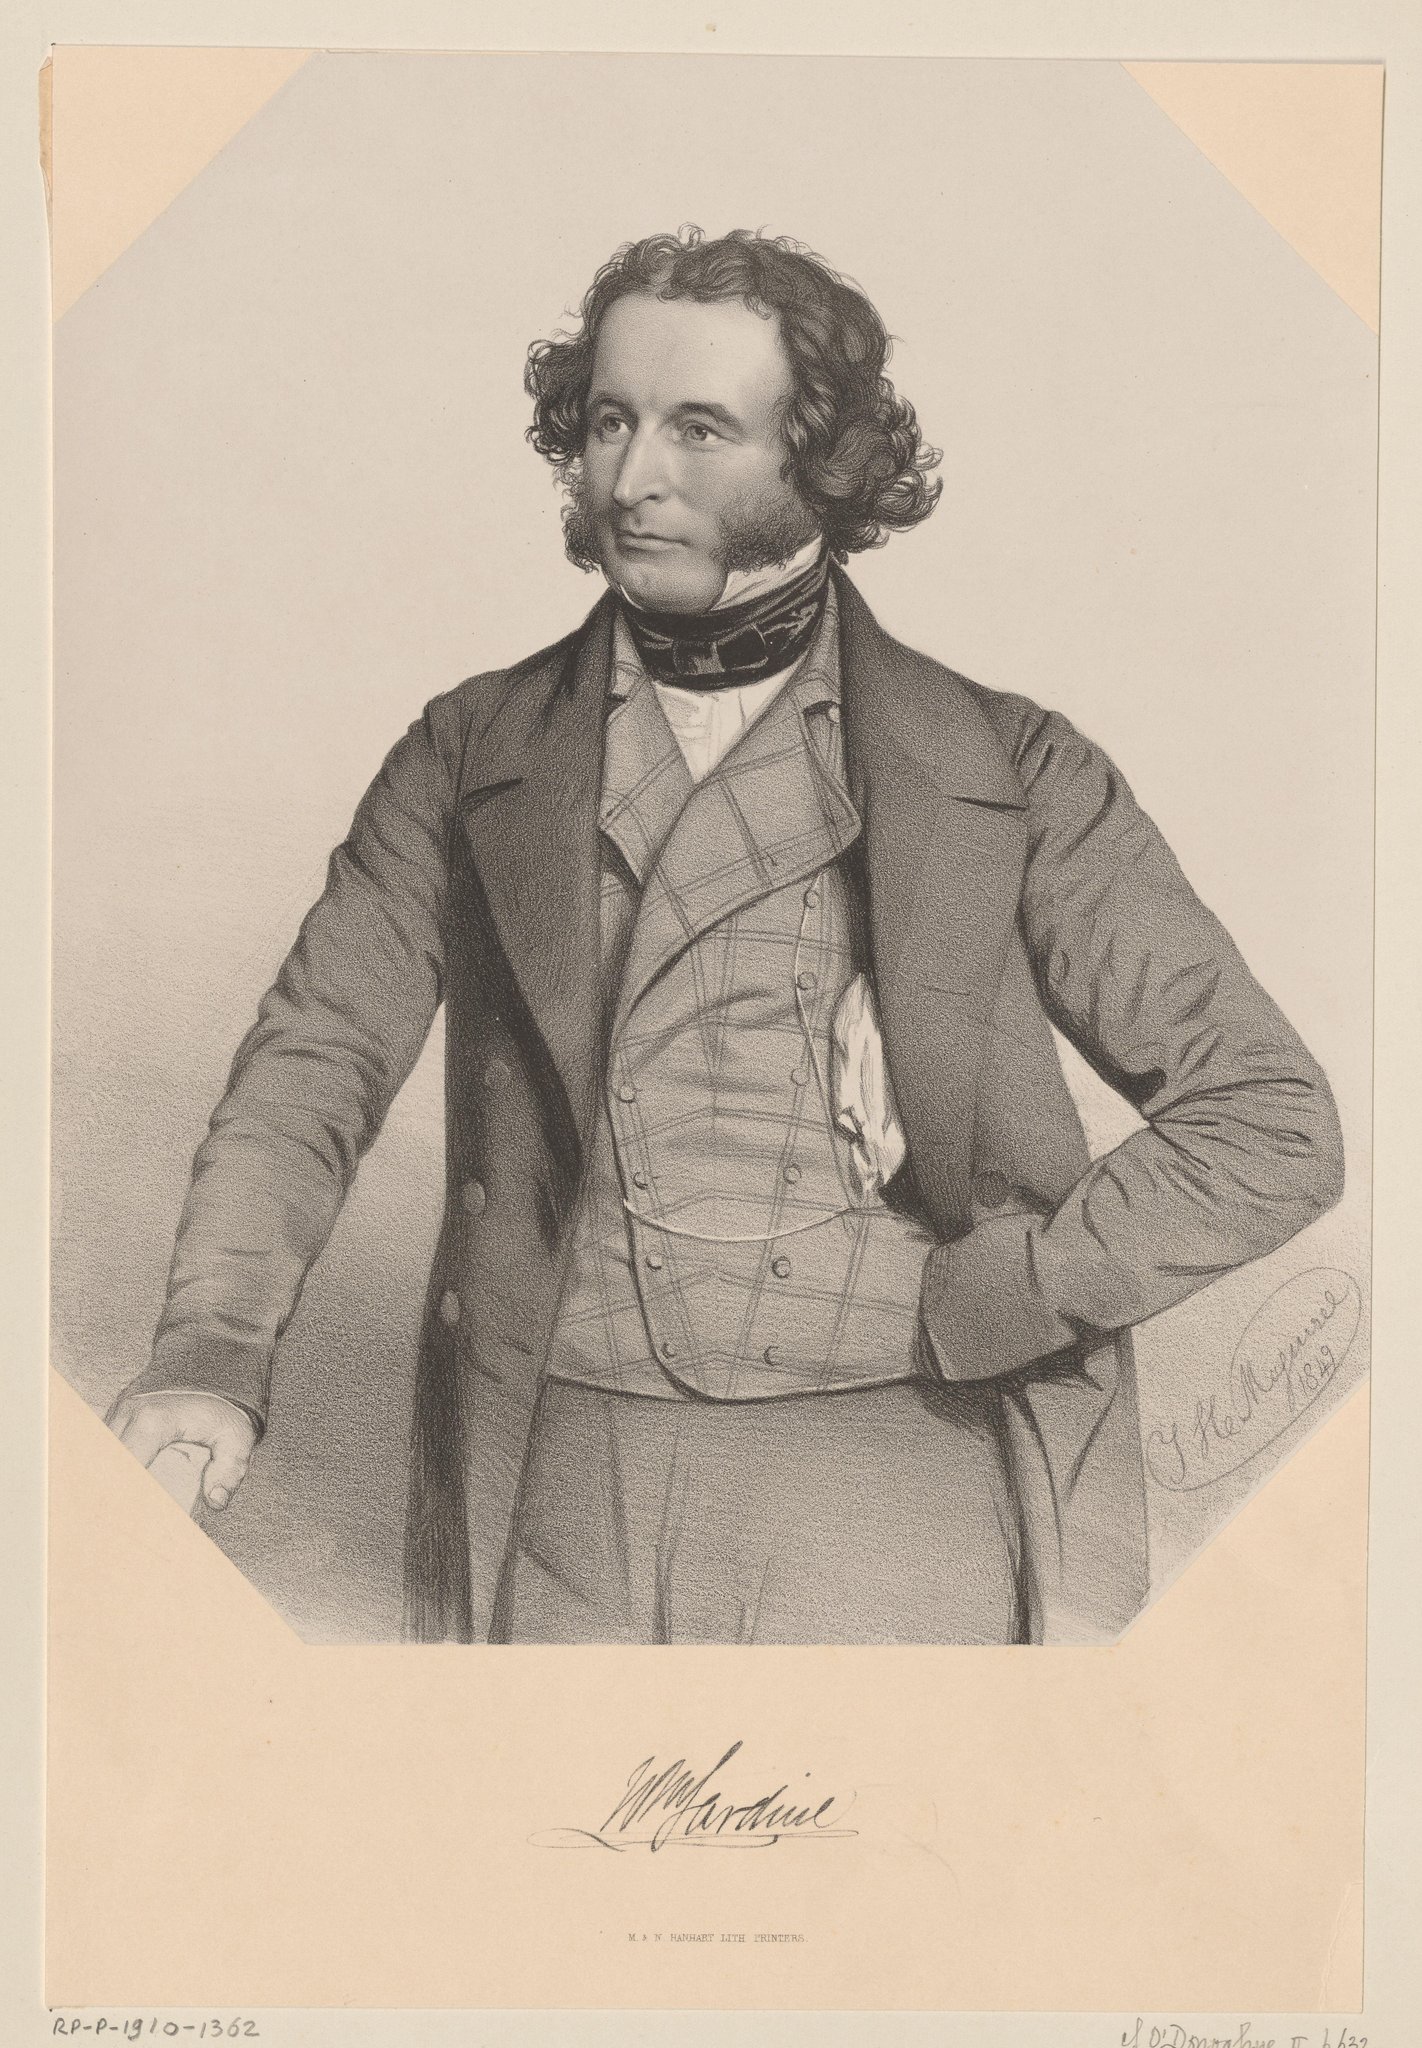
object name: print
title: Portret van William Jardine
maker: thomas herbert maguire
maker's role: print maker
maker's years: 1821-1895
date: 1849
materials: paper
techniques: lithograph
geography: london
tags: historical persons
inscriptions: collector's mark: Lugt 2228